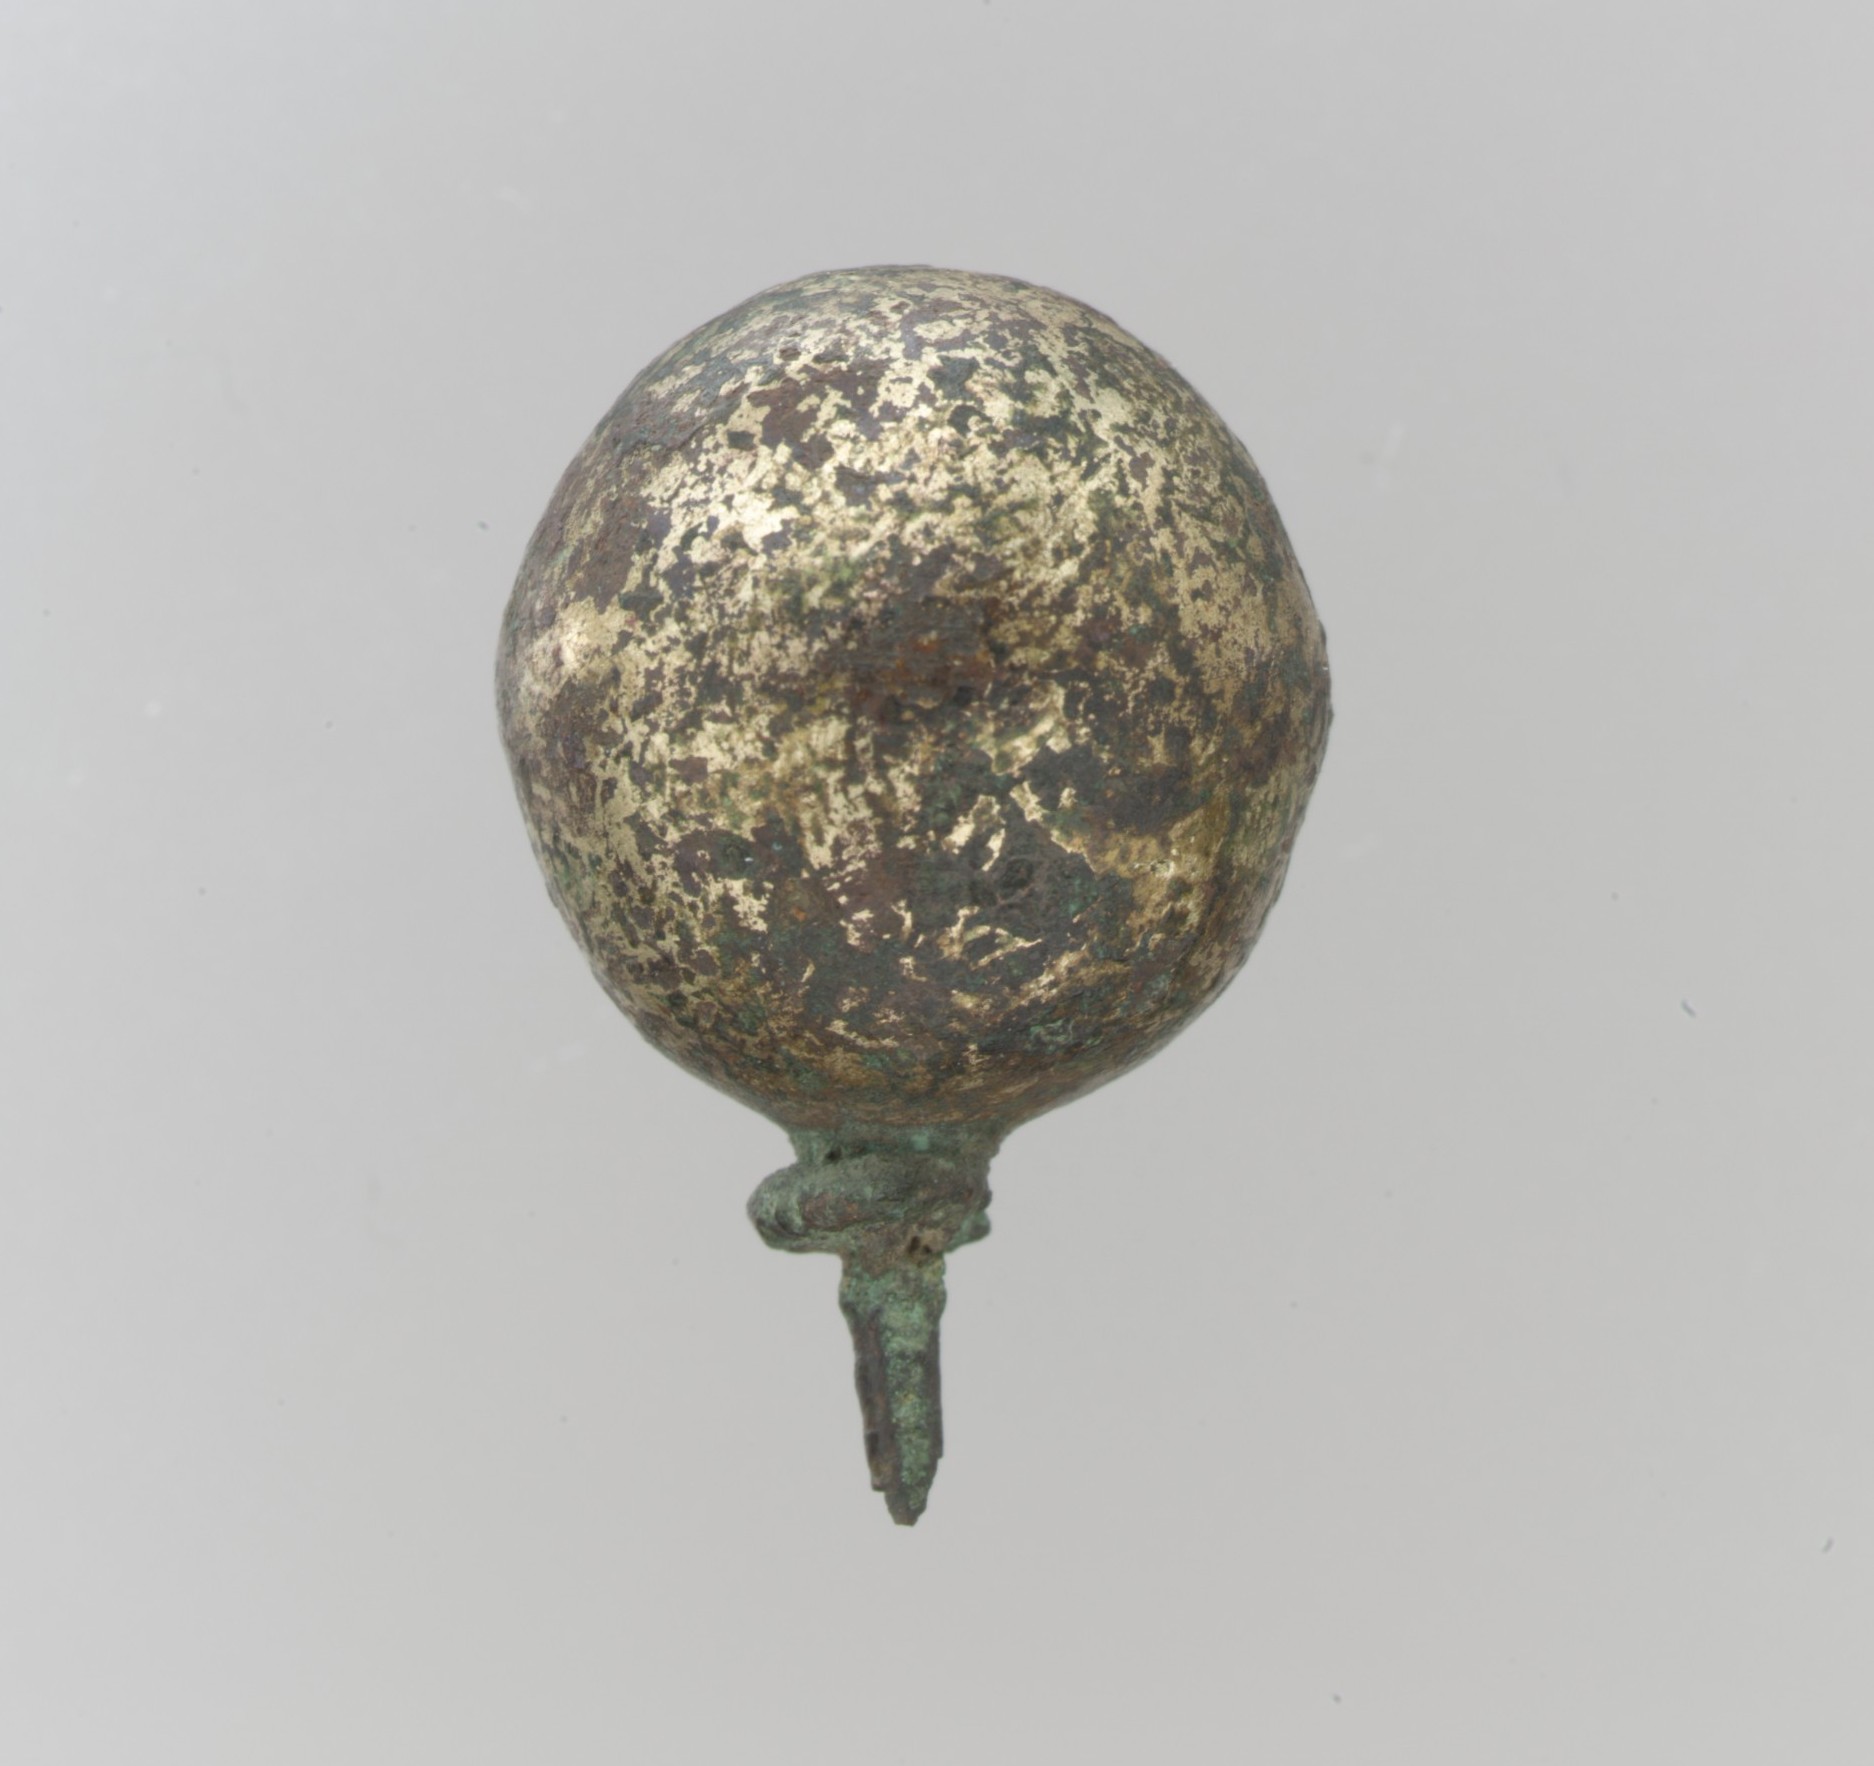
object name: hairpin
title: Hairpin Knob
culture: roman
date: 1-400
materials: bronze, gilt